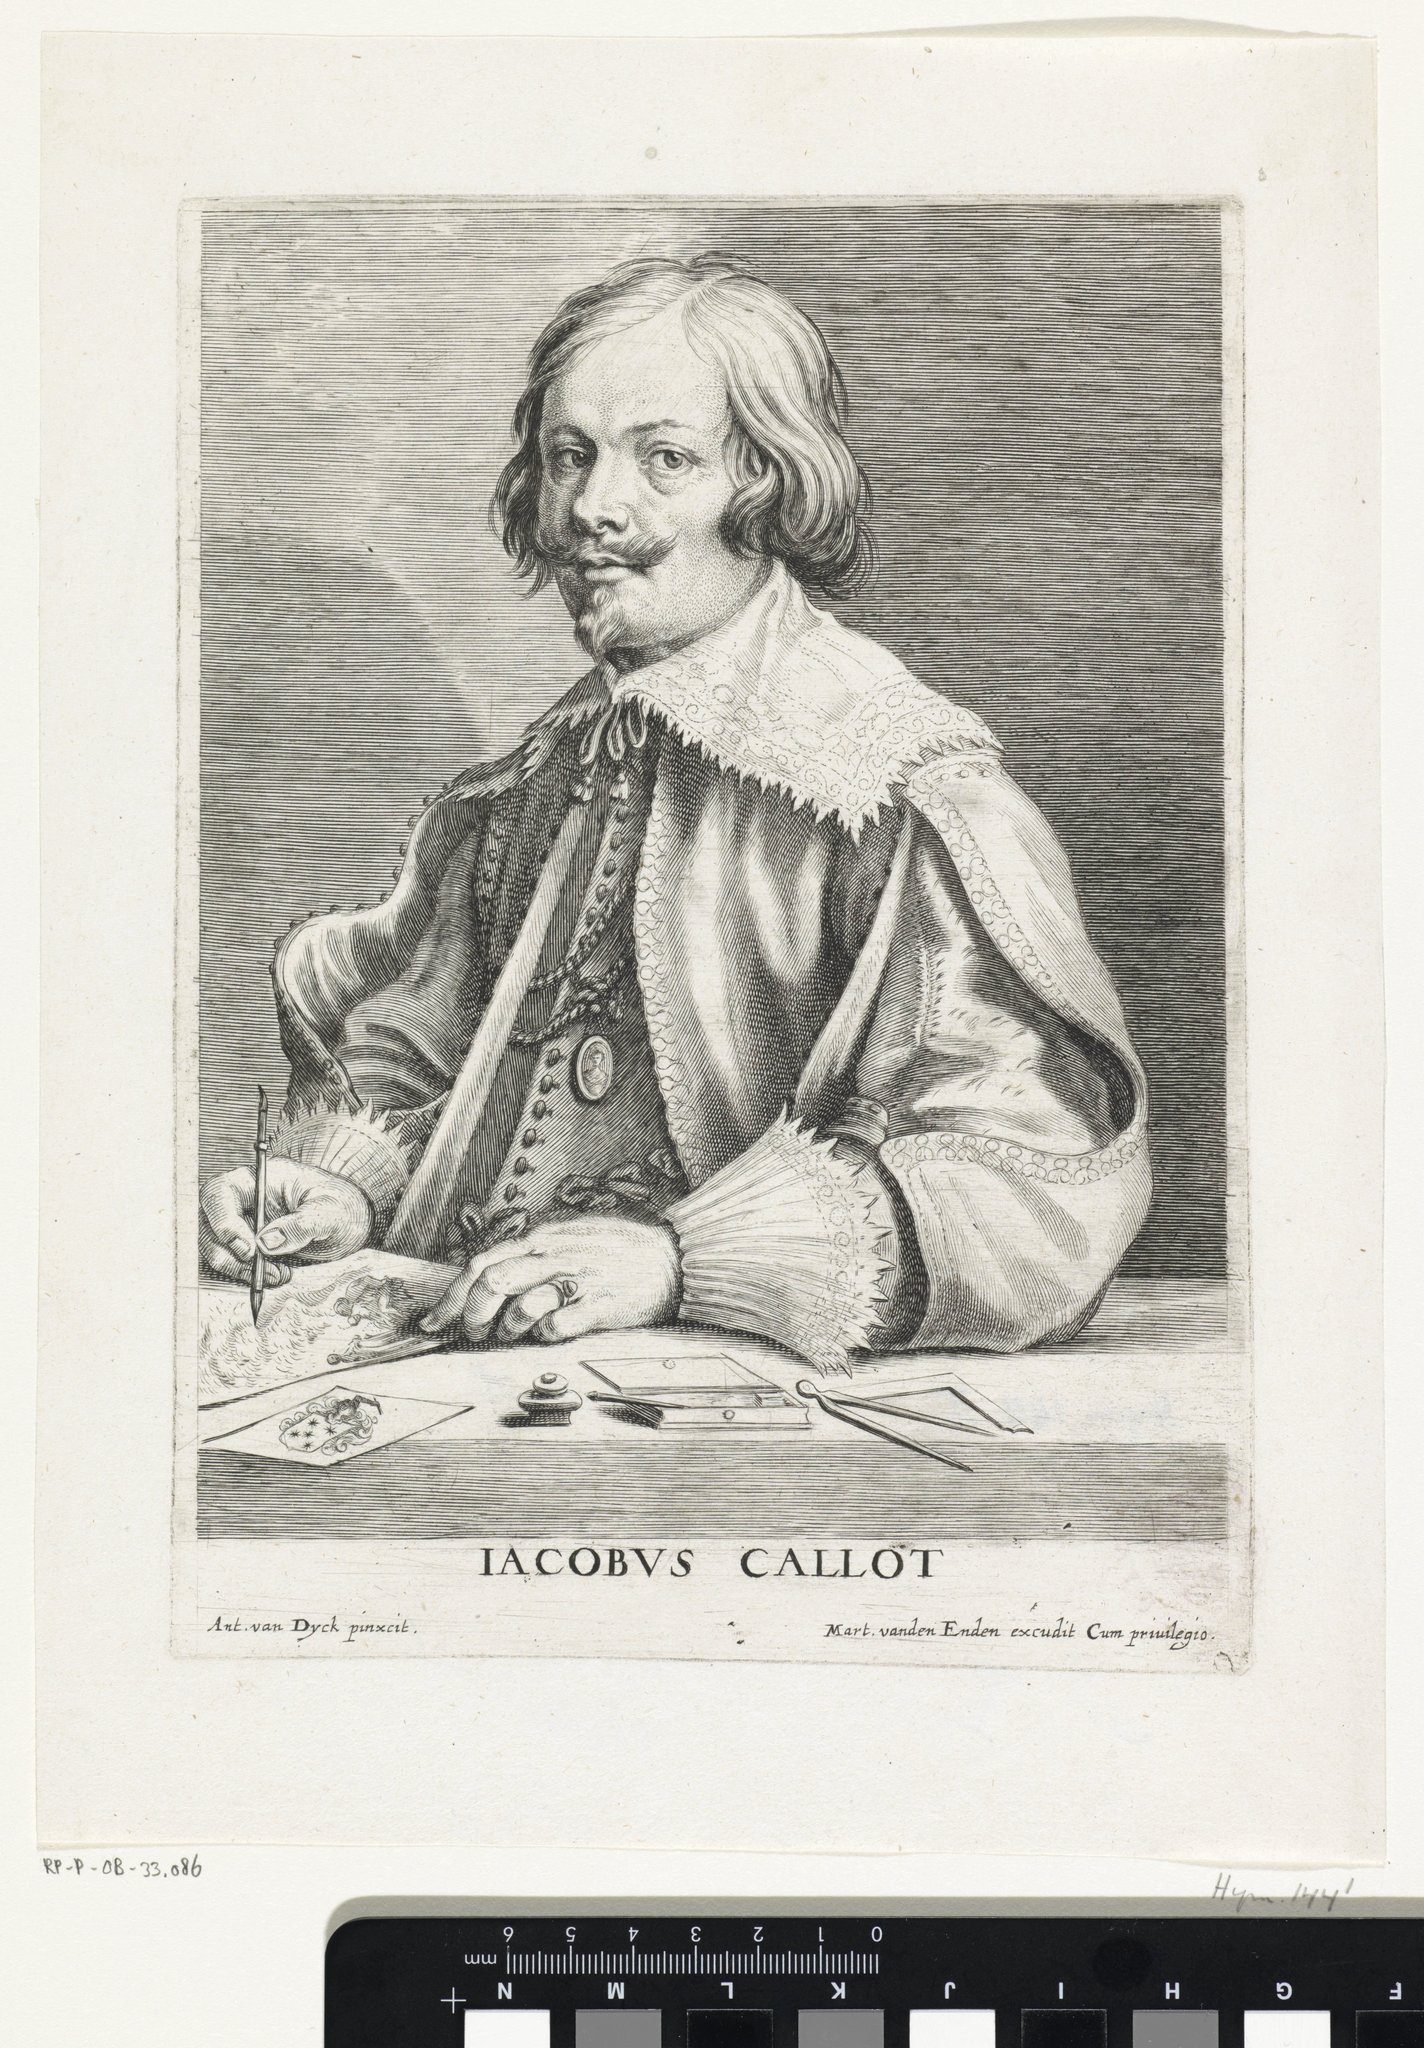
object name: print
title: Portret van Jacques Callot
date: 1630-1646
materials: paper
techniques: engraving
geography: antwerp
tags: draughtsman, jacques callot, print, e.g.: engraving, etching, lithograph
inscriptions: collector's mark: Lugt 240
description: Prent gebruikt voor: Icones principum, virorum doctorum, pictorum, chalcographorum, statuariorum nec non amatorum pictoriae artis numero centum ab Ant. van Dyck ad vivum expressae ejusque sumptibus aeri incisae. Antwerpen: Gillis Hendricx, [1645-1646].